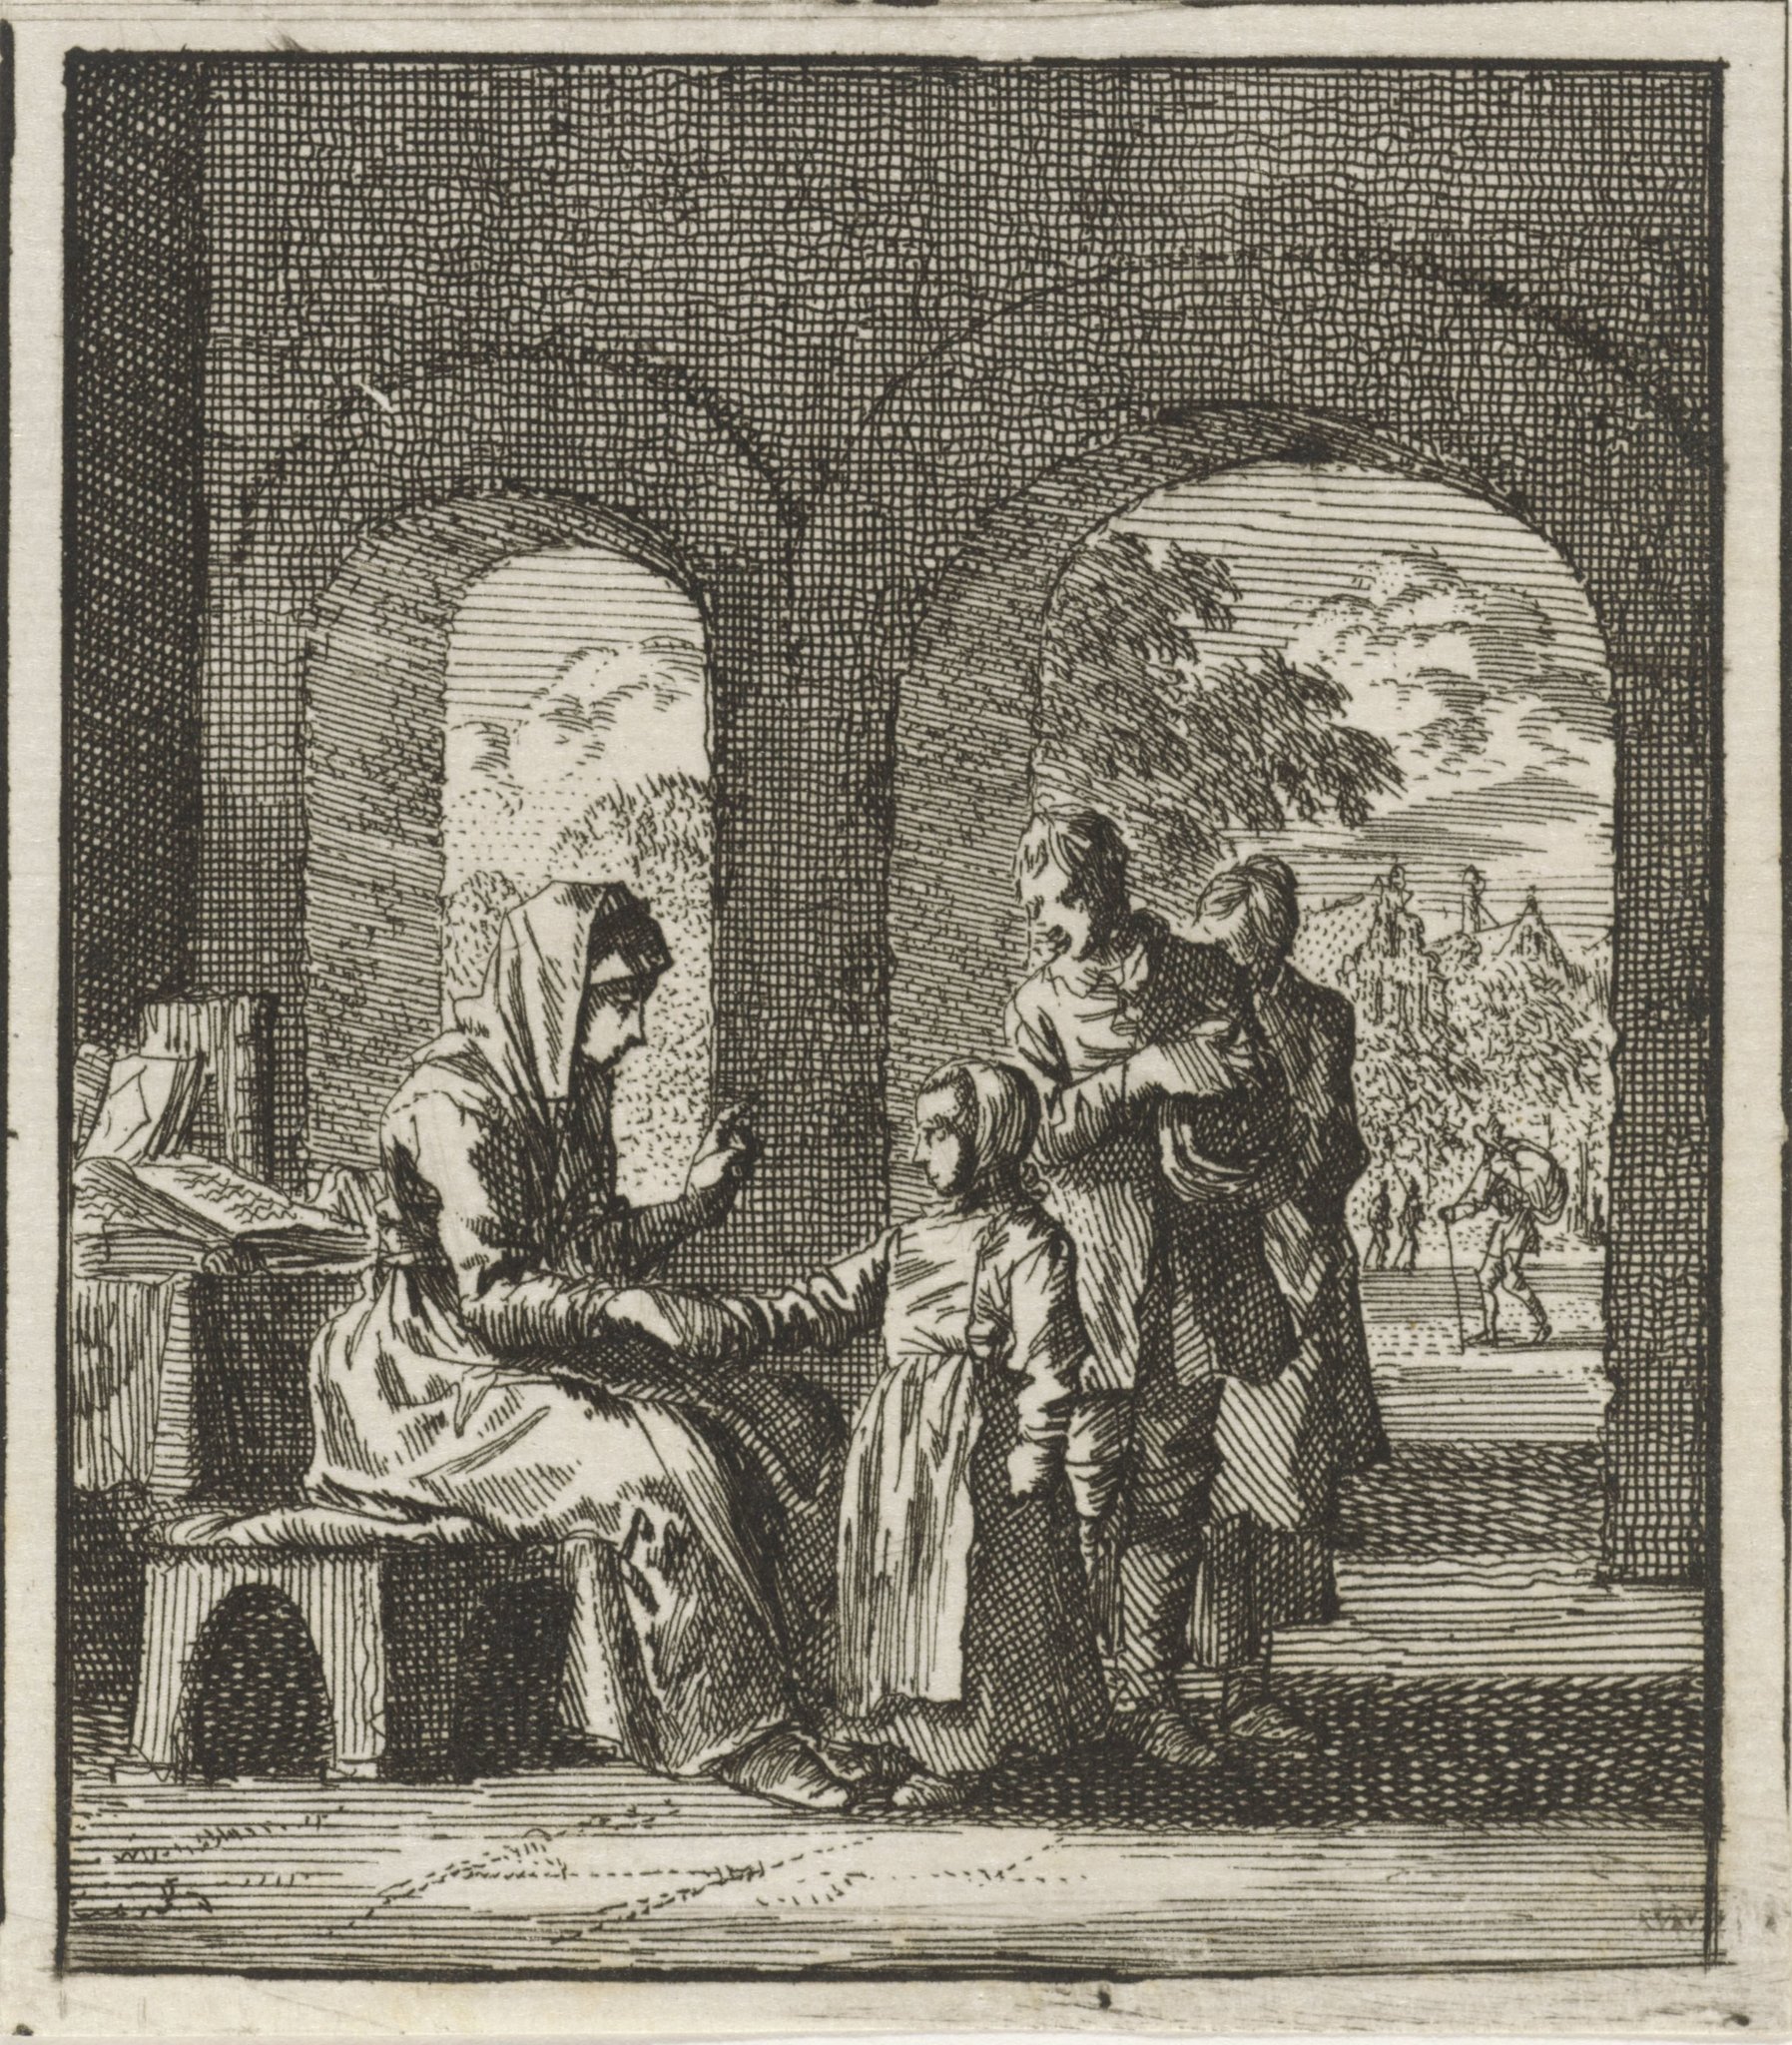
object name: print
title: Moeder spreekt haar kind vermanend toe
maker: jan luyken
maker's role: draughtsman, print maker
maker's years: 1649-1712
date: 1712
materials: paper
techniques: etching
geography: amsterdam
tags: correction of naughty children, mother and baby or young child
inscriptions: collector's mark: Lugt 2228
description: Proefdruk van illustratie uit: Luyken, Jan. Des menschen begin, midden en einde. Amsterdam: Wed. Pieter Arentsz II en Cornelis van der Sys, 1712, p. 45.